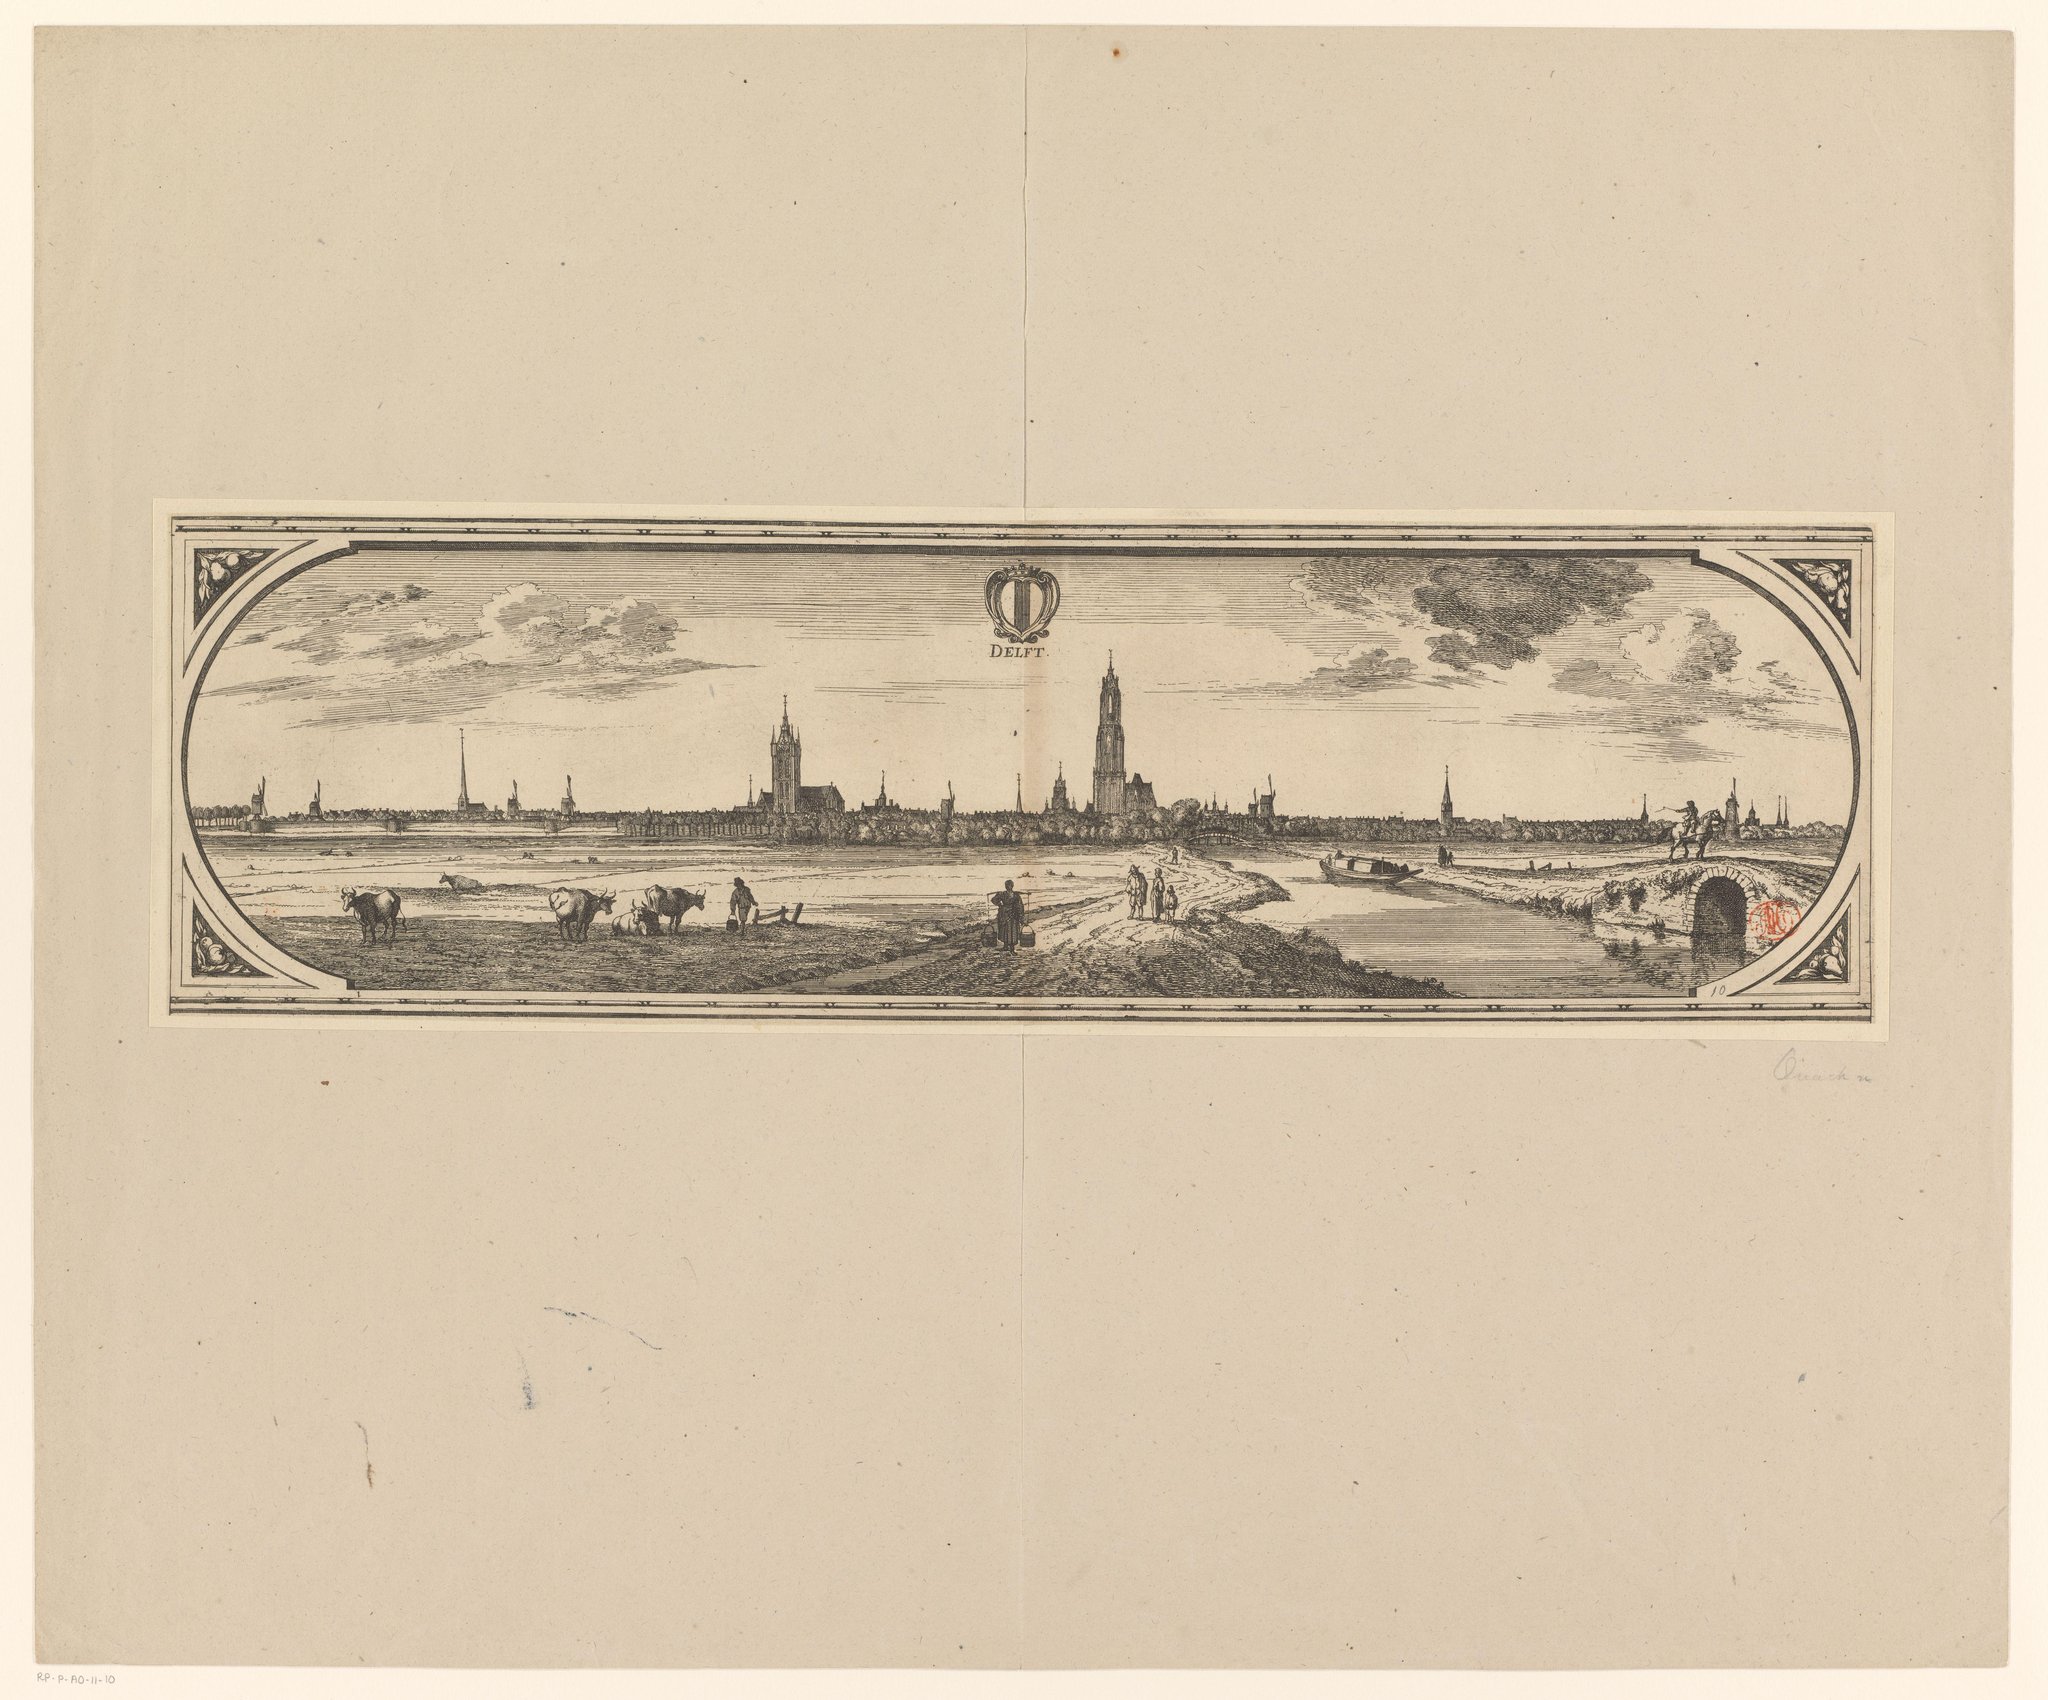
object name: print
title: Delft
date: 1666-1698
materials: paper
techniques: engraving, etching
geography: rotterdam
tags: coat of arms (as symbol of the state, etc.) (+ city; municipal), river, church (exterior), bridge, windmill, prospect of city, town panorama, silhouette of city, delft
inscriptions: collector's mark: Lugt 195, collector's mark: Lugt 2228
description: Gezicht op Delft gezien vanaf de Delftse Schie. In het midden de Nieuwe Kerk en links de Oude Kerk. Boven in het midden het wapen van de stad en de titel.